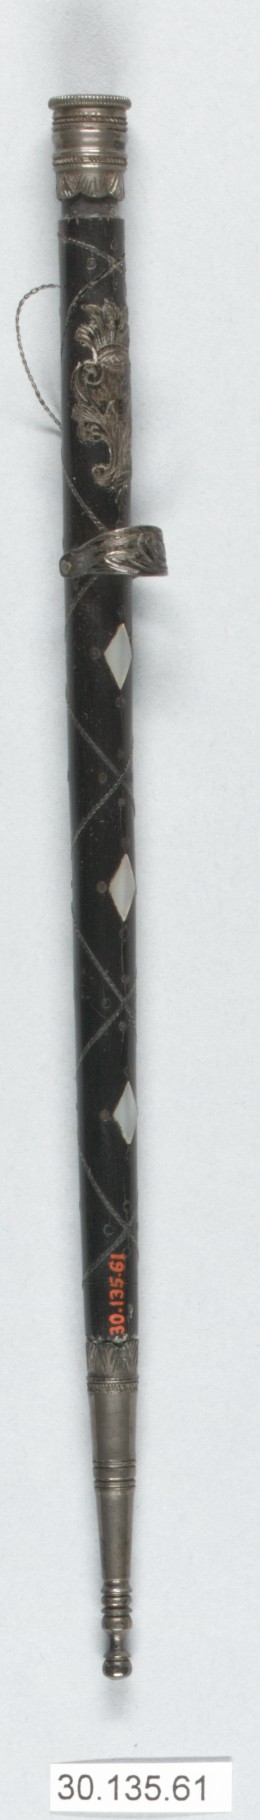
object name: needle sheath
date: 1767-1800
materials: metal, wood